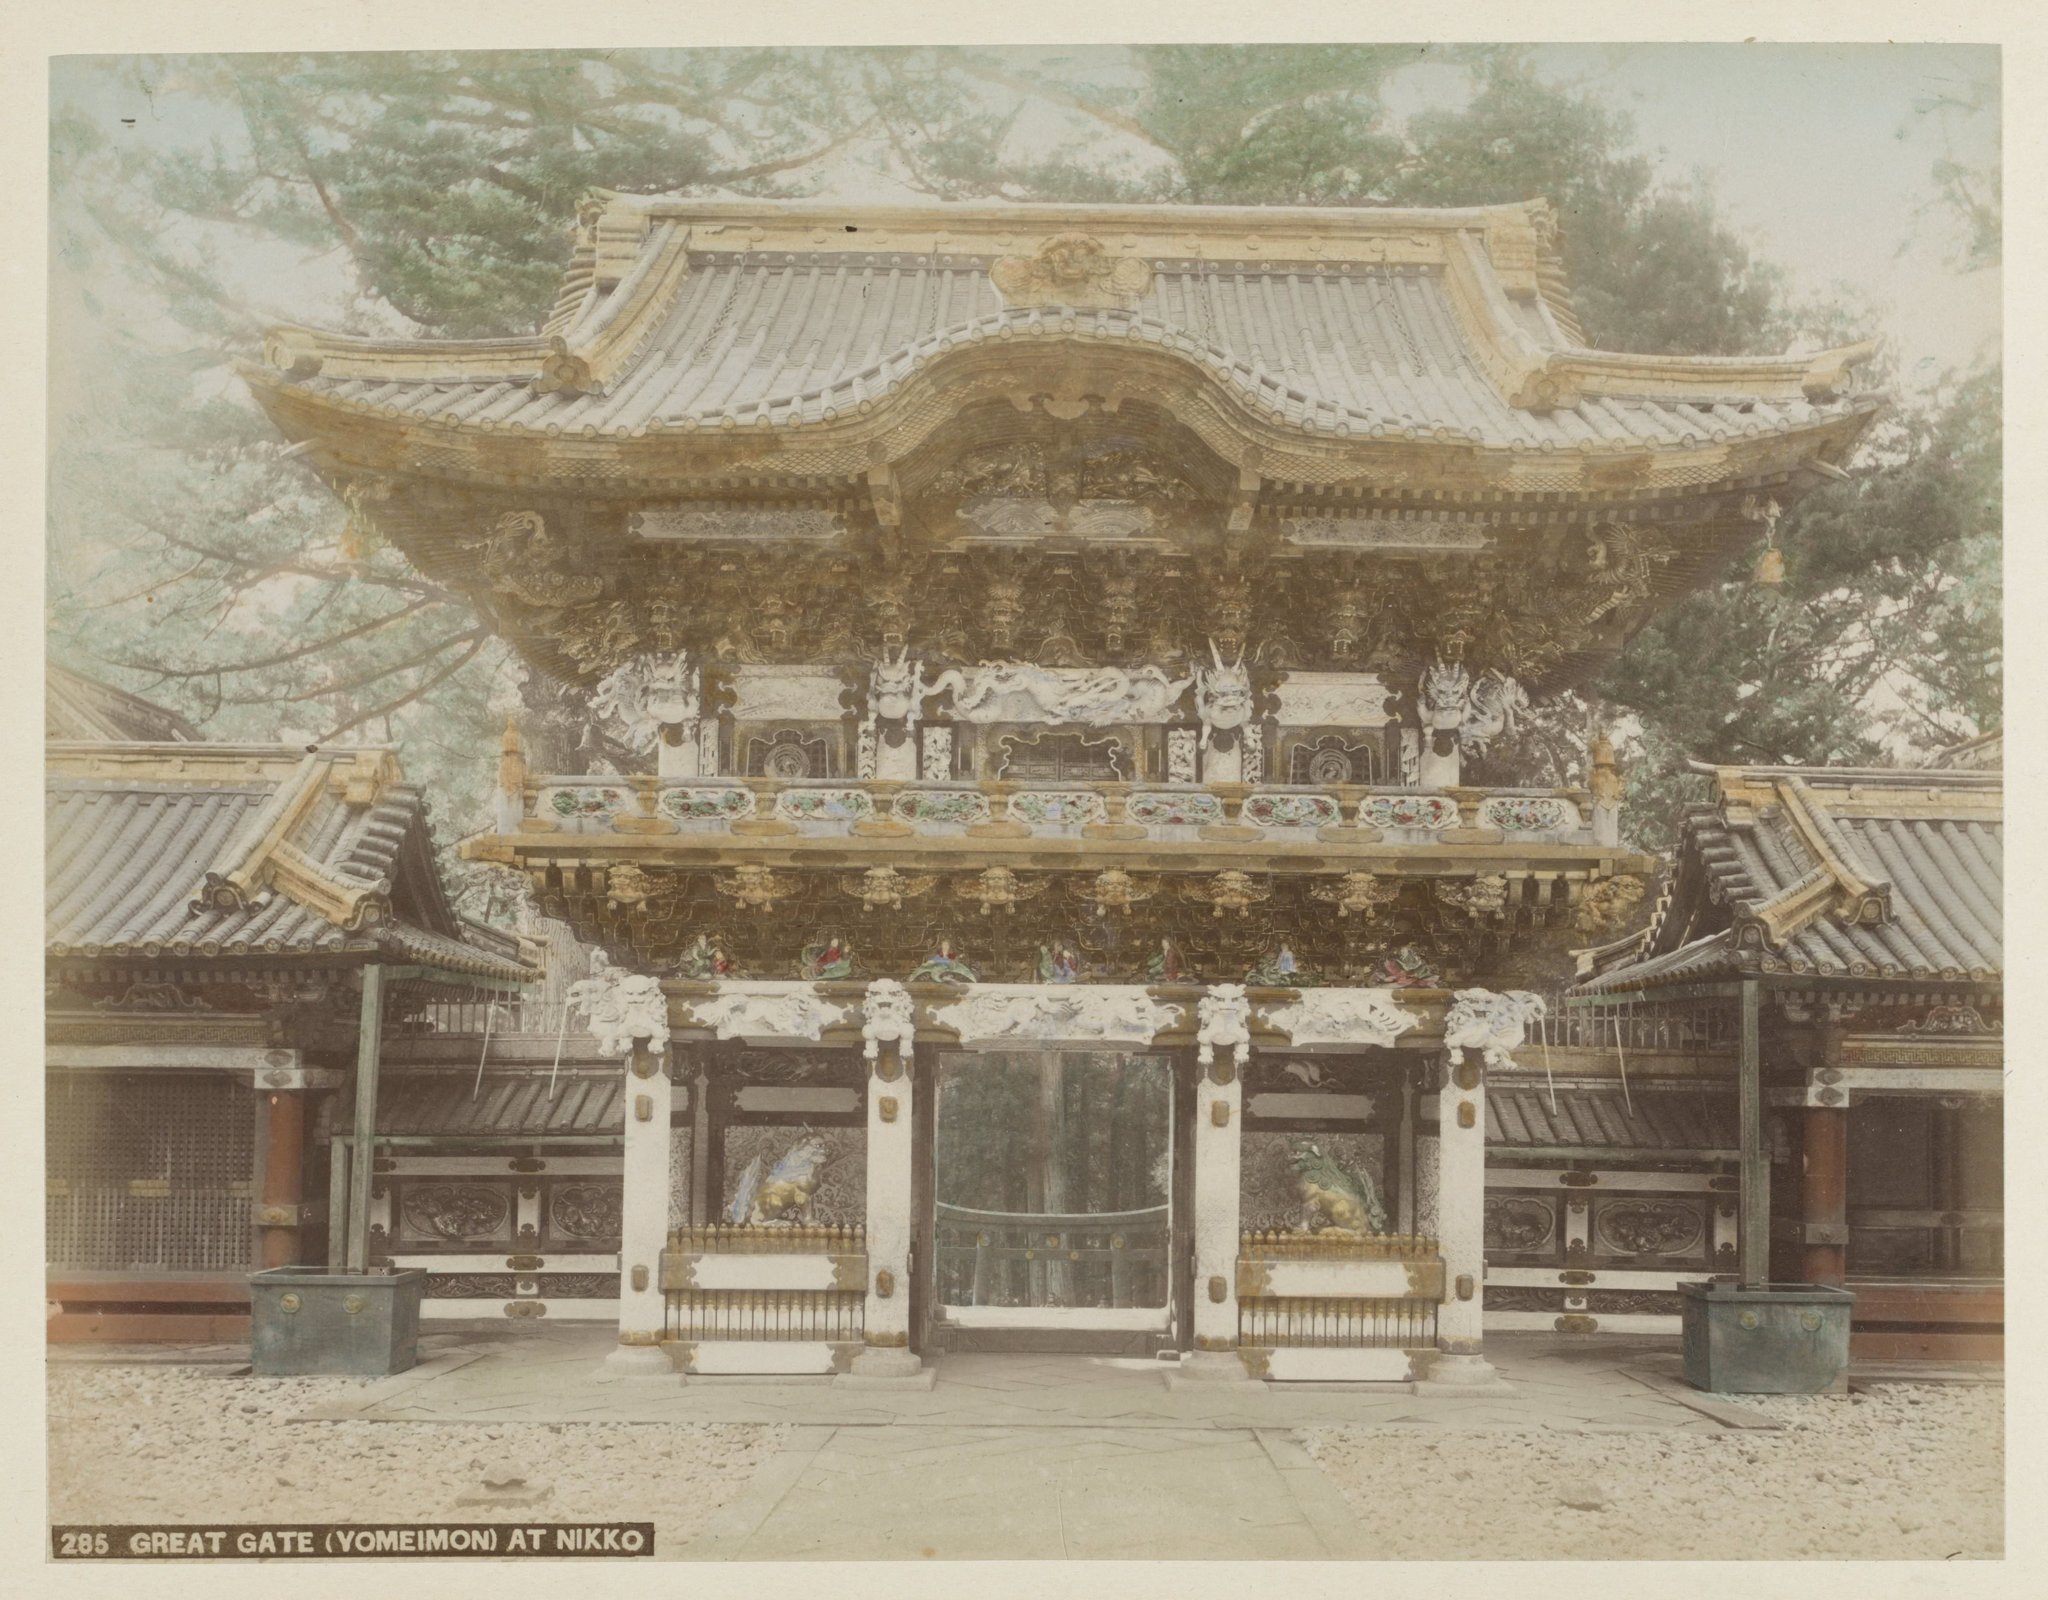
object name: photograph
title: Great Gate (Yomeimon) at Nikko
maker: Anonymous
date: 1870-1900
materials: paper, photographic support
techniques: albumen print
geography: nikko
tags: temple, shrine ~ hinduism, buddhism, jainism, gate, entrance, travelling; tourism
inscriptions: negative number: ‘285’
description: Onderdeel van Fotoalbum met 50 foto's van bezienswaardigheden in Japan.